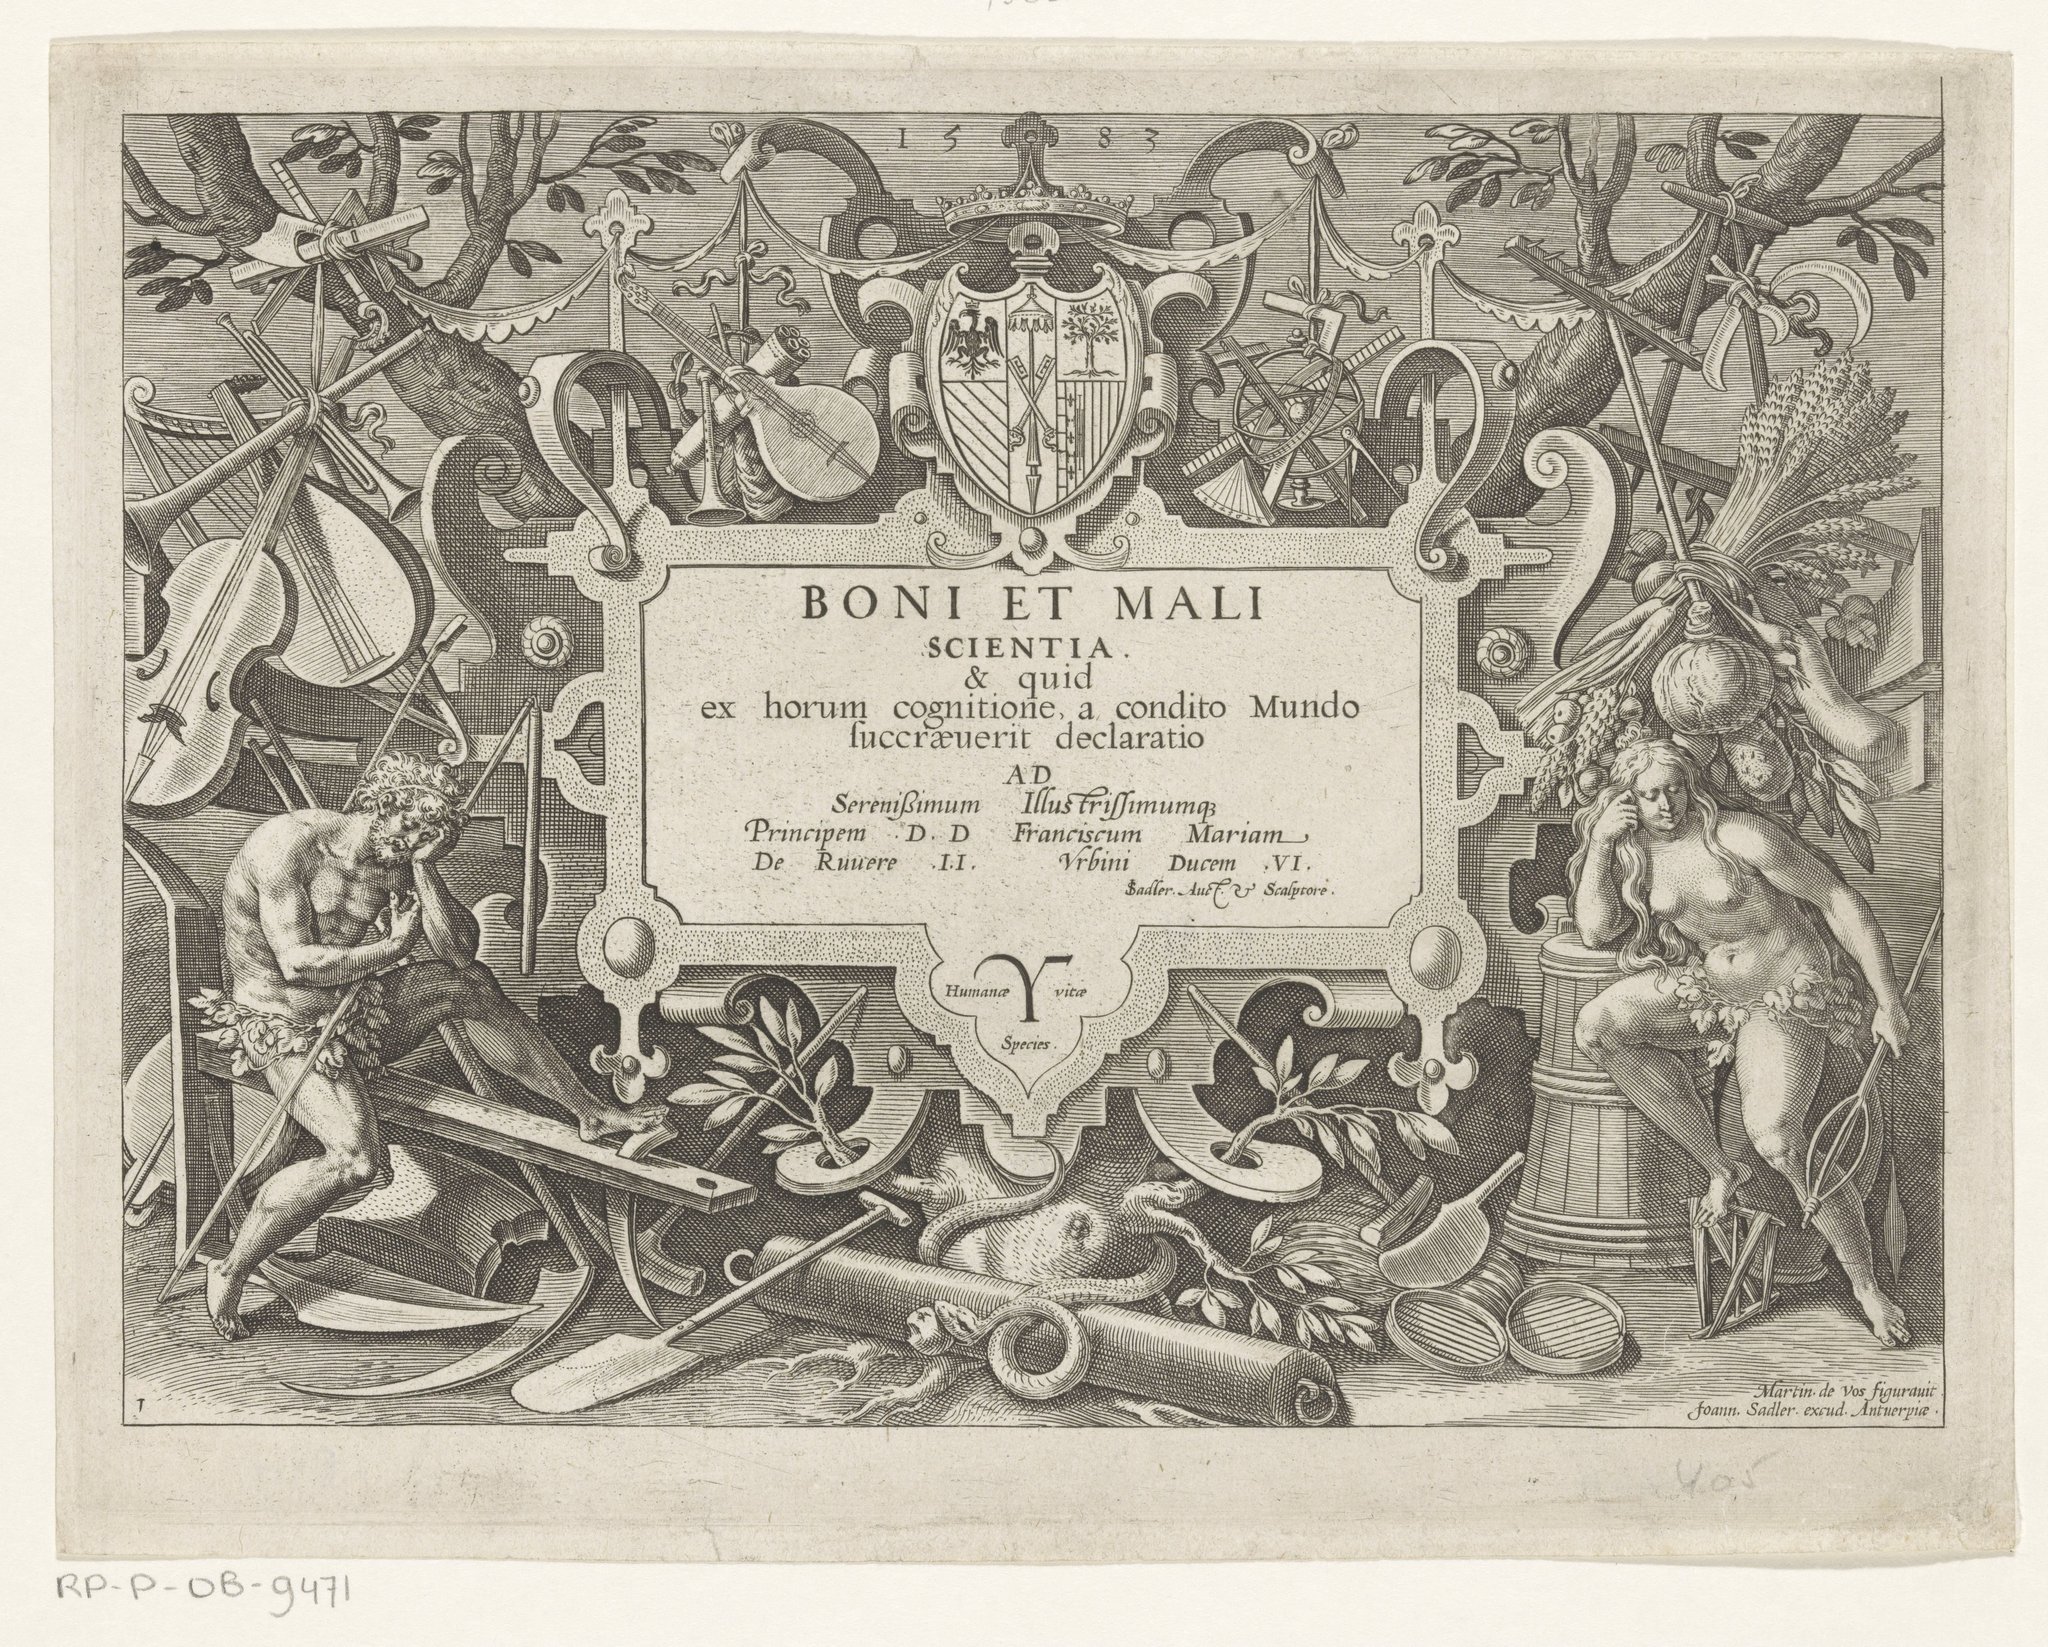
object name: print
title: Geschiedenis van de familie van Kaïn / Over goede en slechte werkzaamheden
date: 1583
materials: paper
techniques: engraving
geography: antwerp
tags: ornaments ~ art (+ framing decorations), adam and eve (not in biblical context)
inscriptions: collector's mark: Lugt 2228, collector's mark: Lugt 2760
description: In het midden de titel van de prentreeks in een ornamentele lijst, omgeven door werktuigen, wetenschappelijke instrumenten en muziekinstrumenten. De lijst wordt geflankeerd door Adam en Eva. Midden onder de slang bij de voet van de boom van de kennis van goed en kwaad.